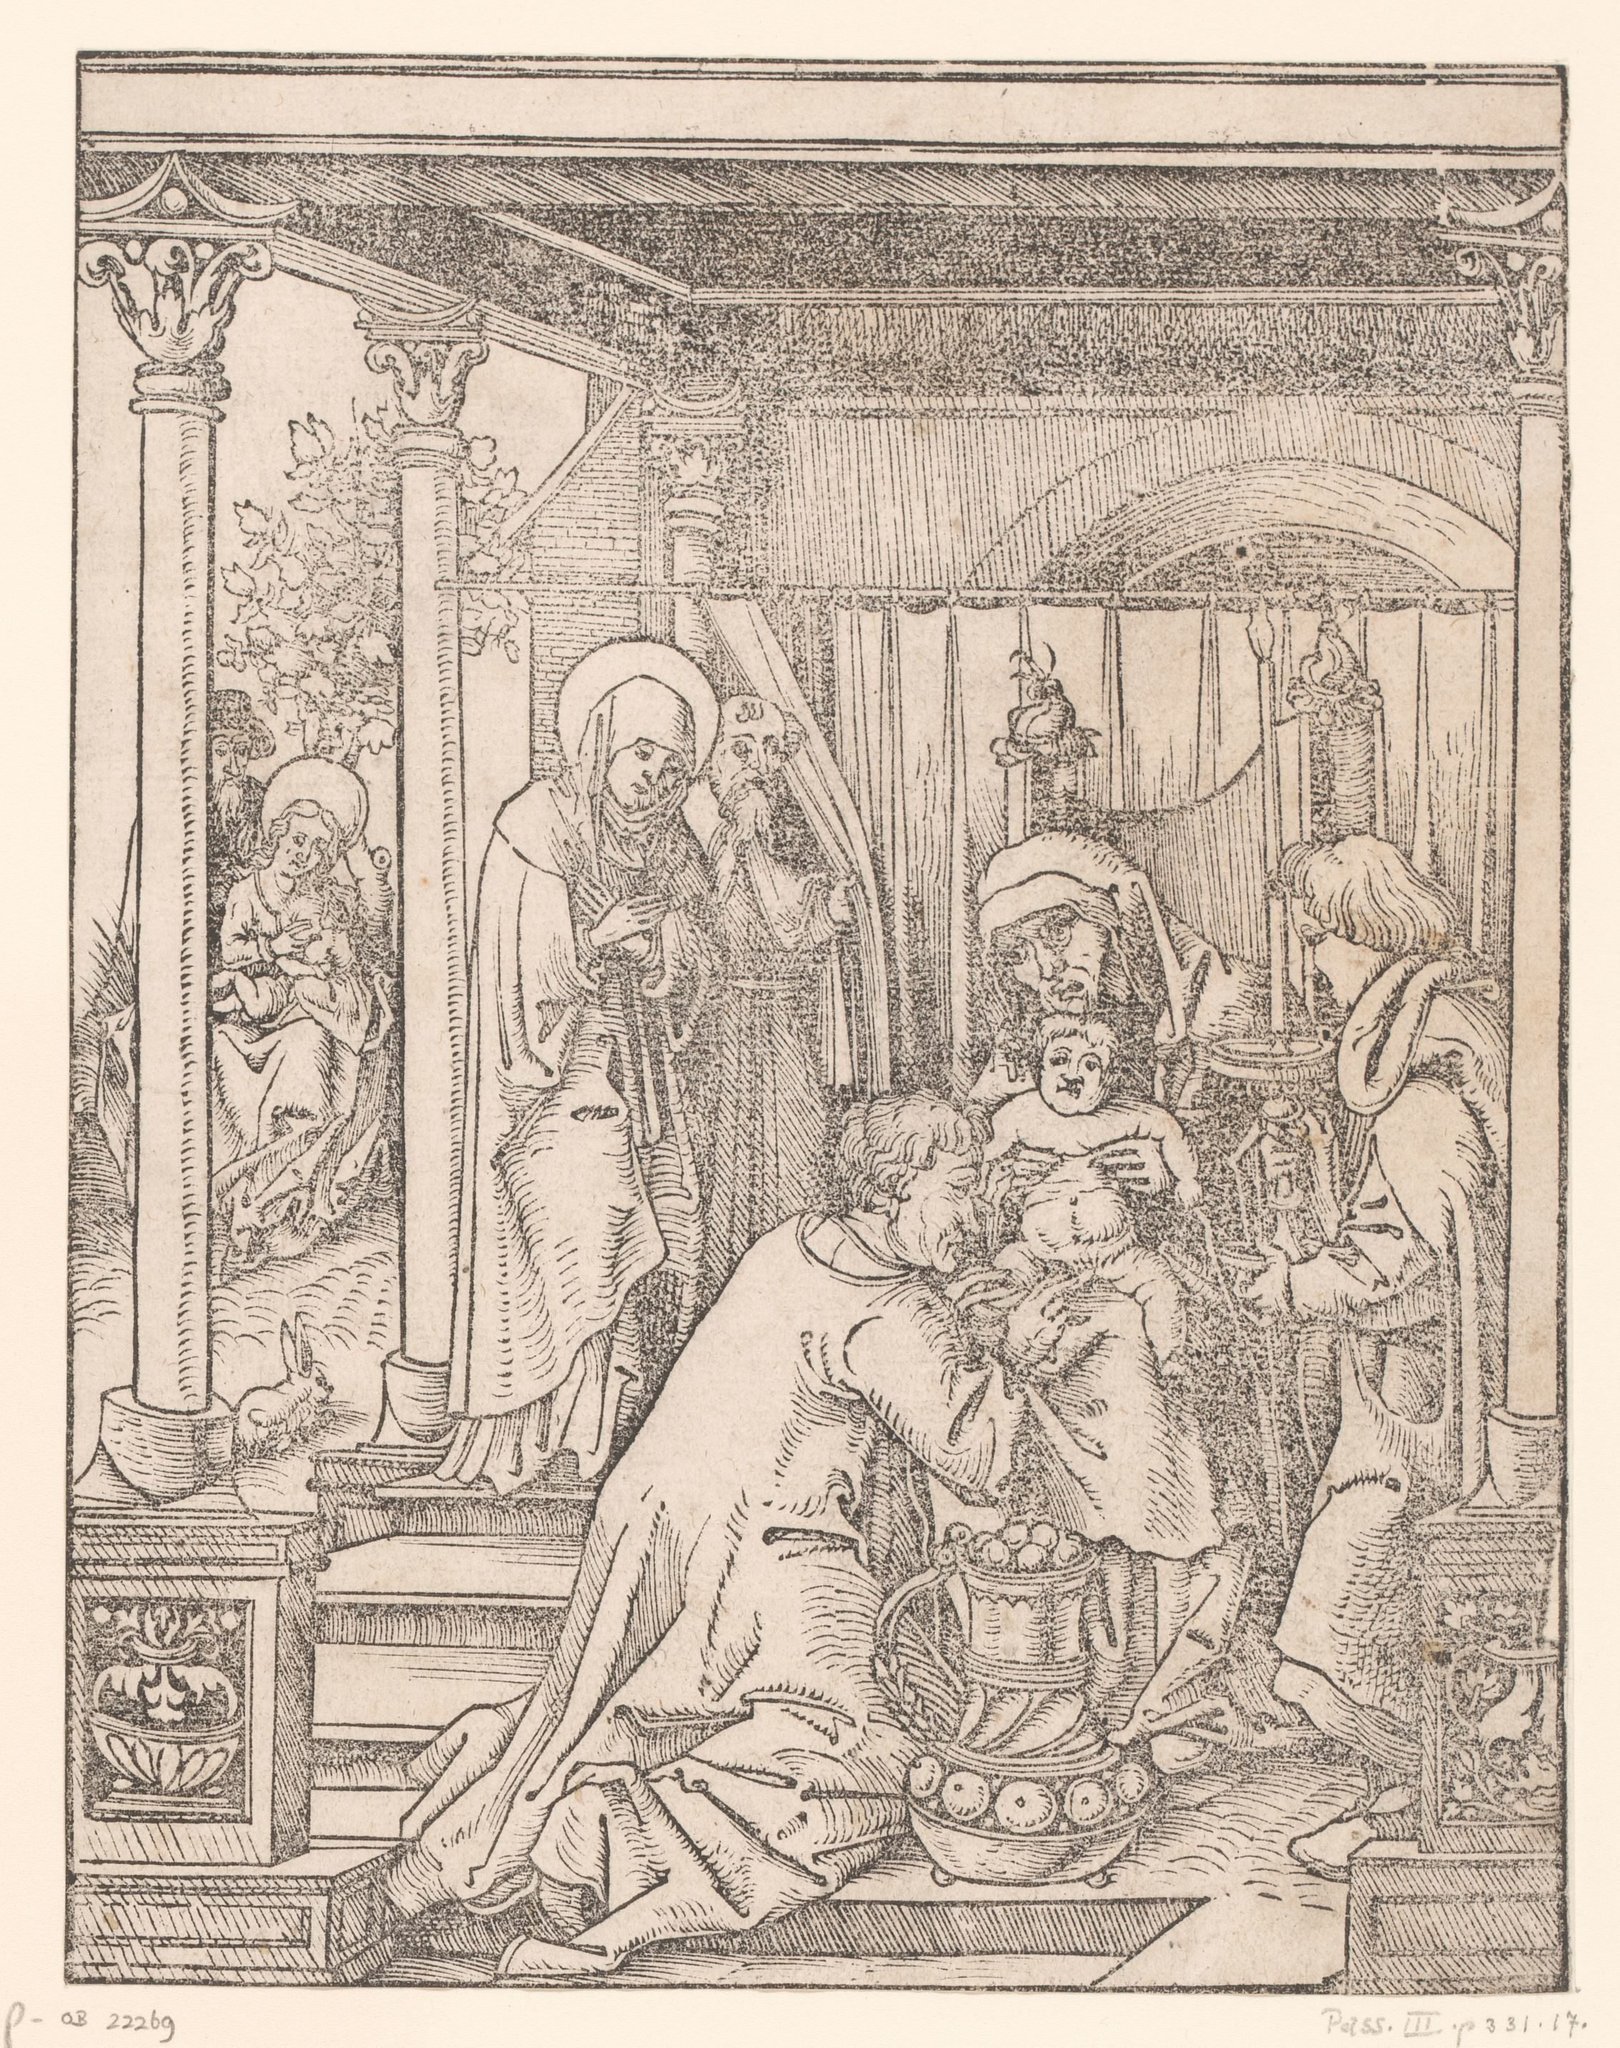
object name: print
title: Besnijdenis van Christus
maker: Anonymous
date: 1490-1526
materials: paper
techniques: woodcut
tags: circumcision of the christ-child by the priest in the temple (luke 2:21)